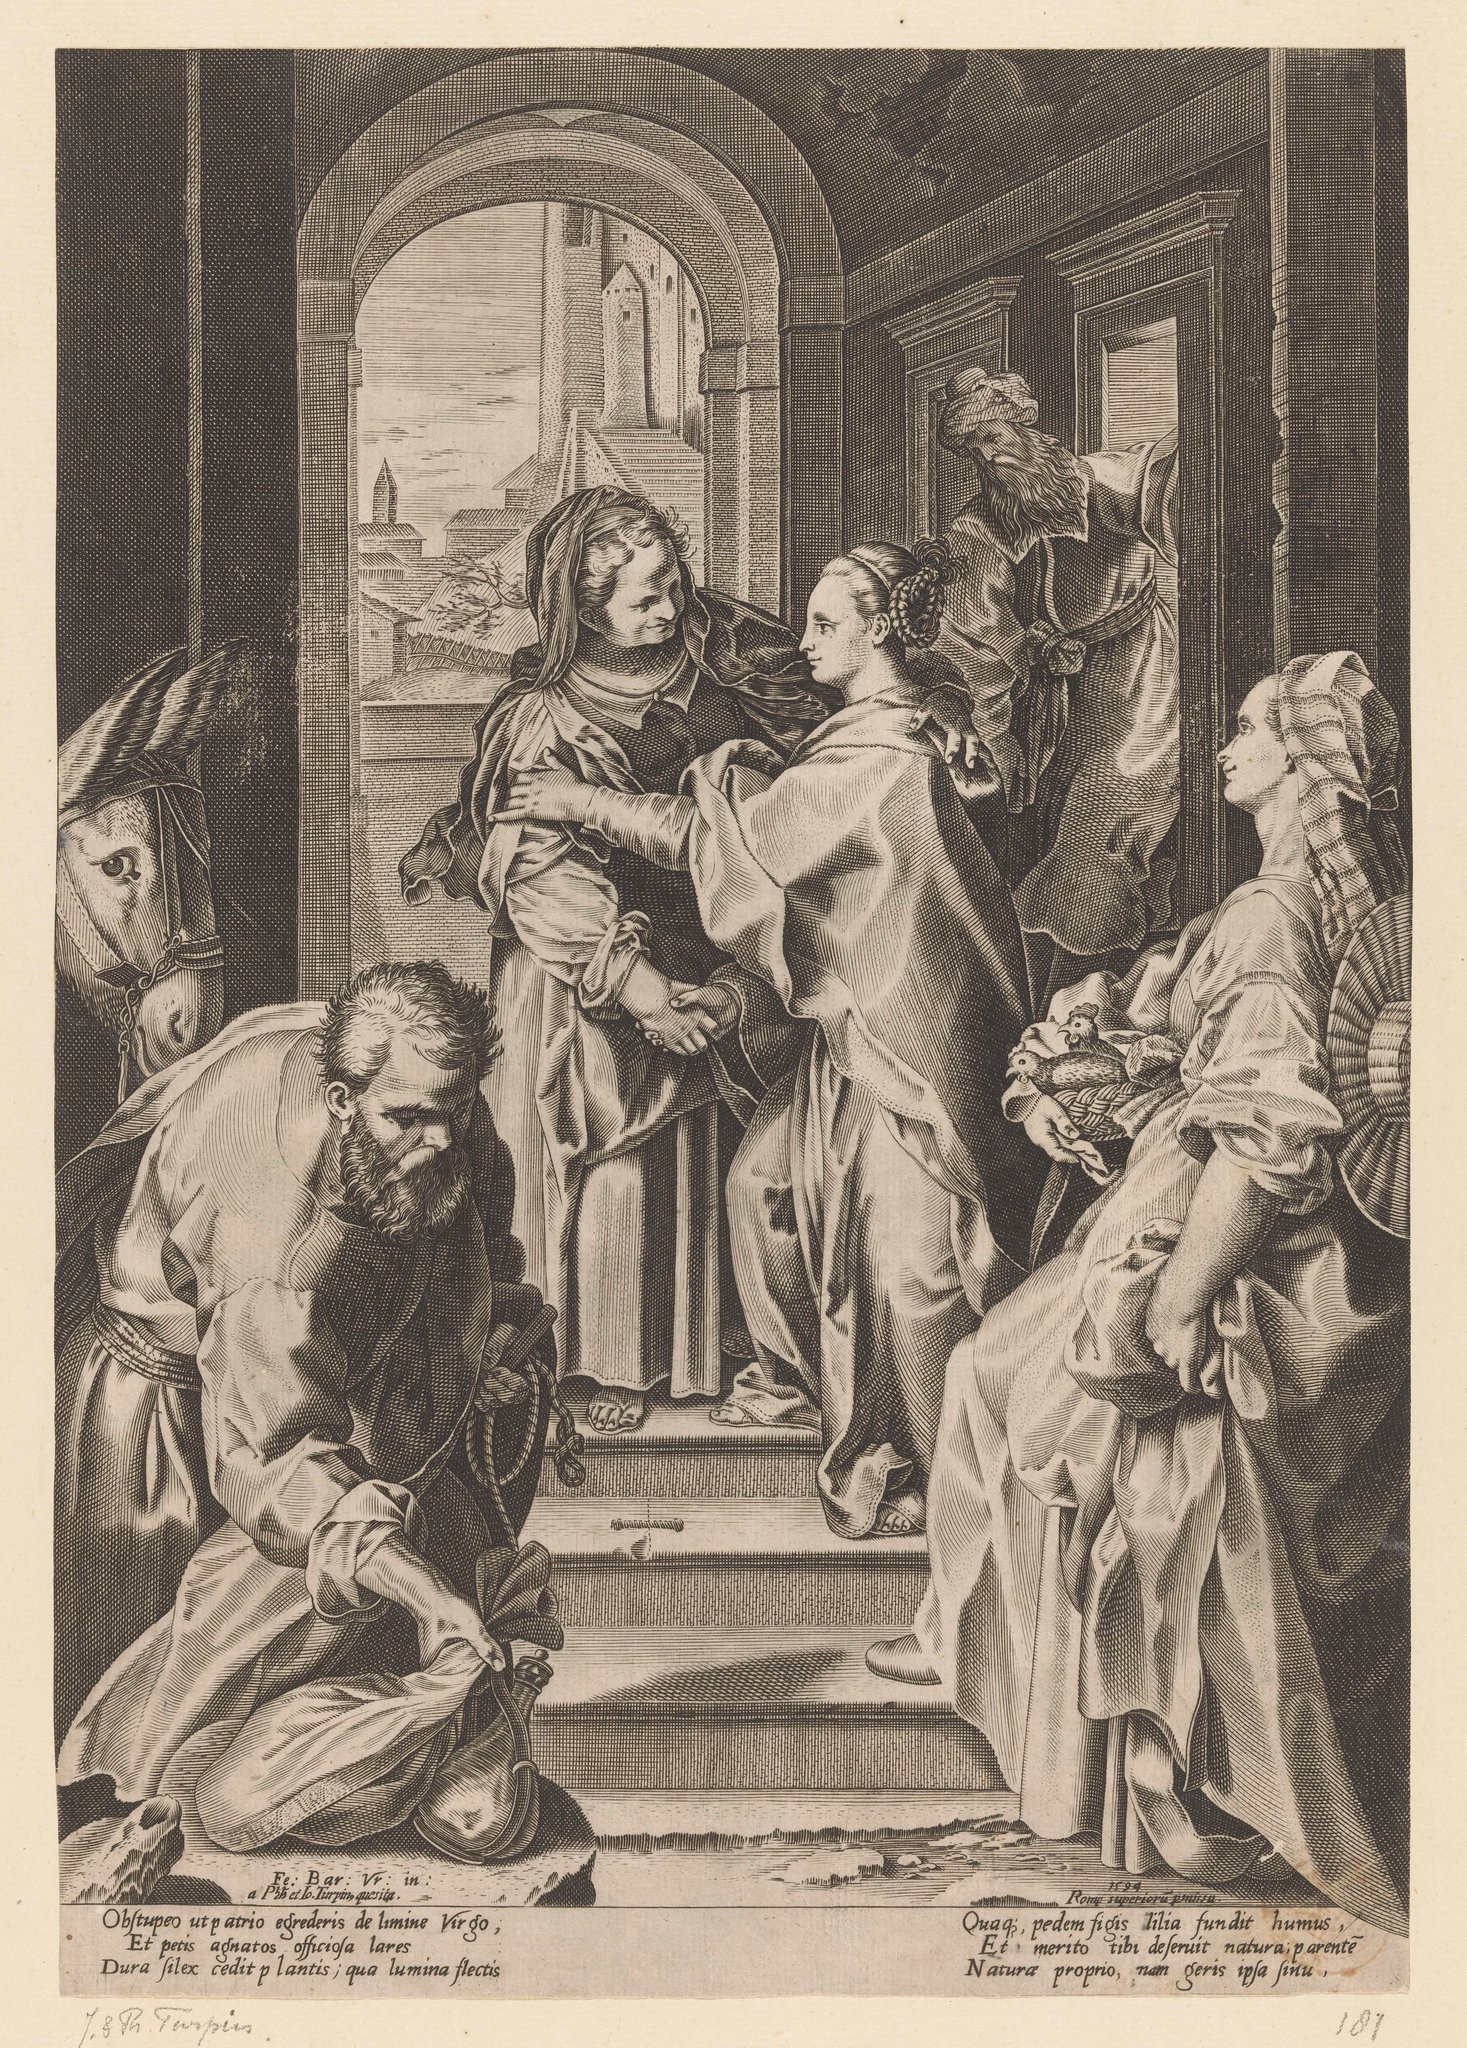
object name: print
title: Visitatie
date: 1594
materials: paper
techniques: engraving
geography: rome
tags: visitation (possibly joseph and/or zacharias present) (luke 1:39-56)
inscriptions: collector's mark: Lugt 240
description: Het originele schilderij door Barocci bevindt zich in de Santa Maria in Vallicella te Rome.